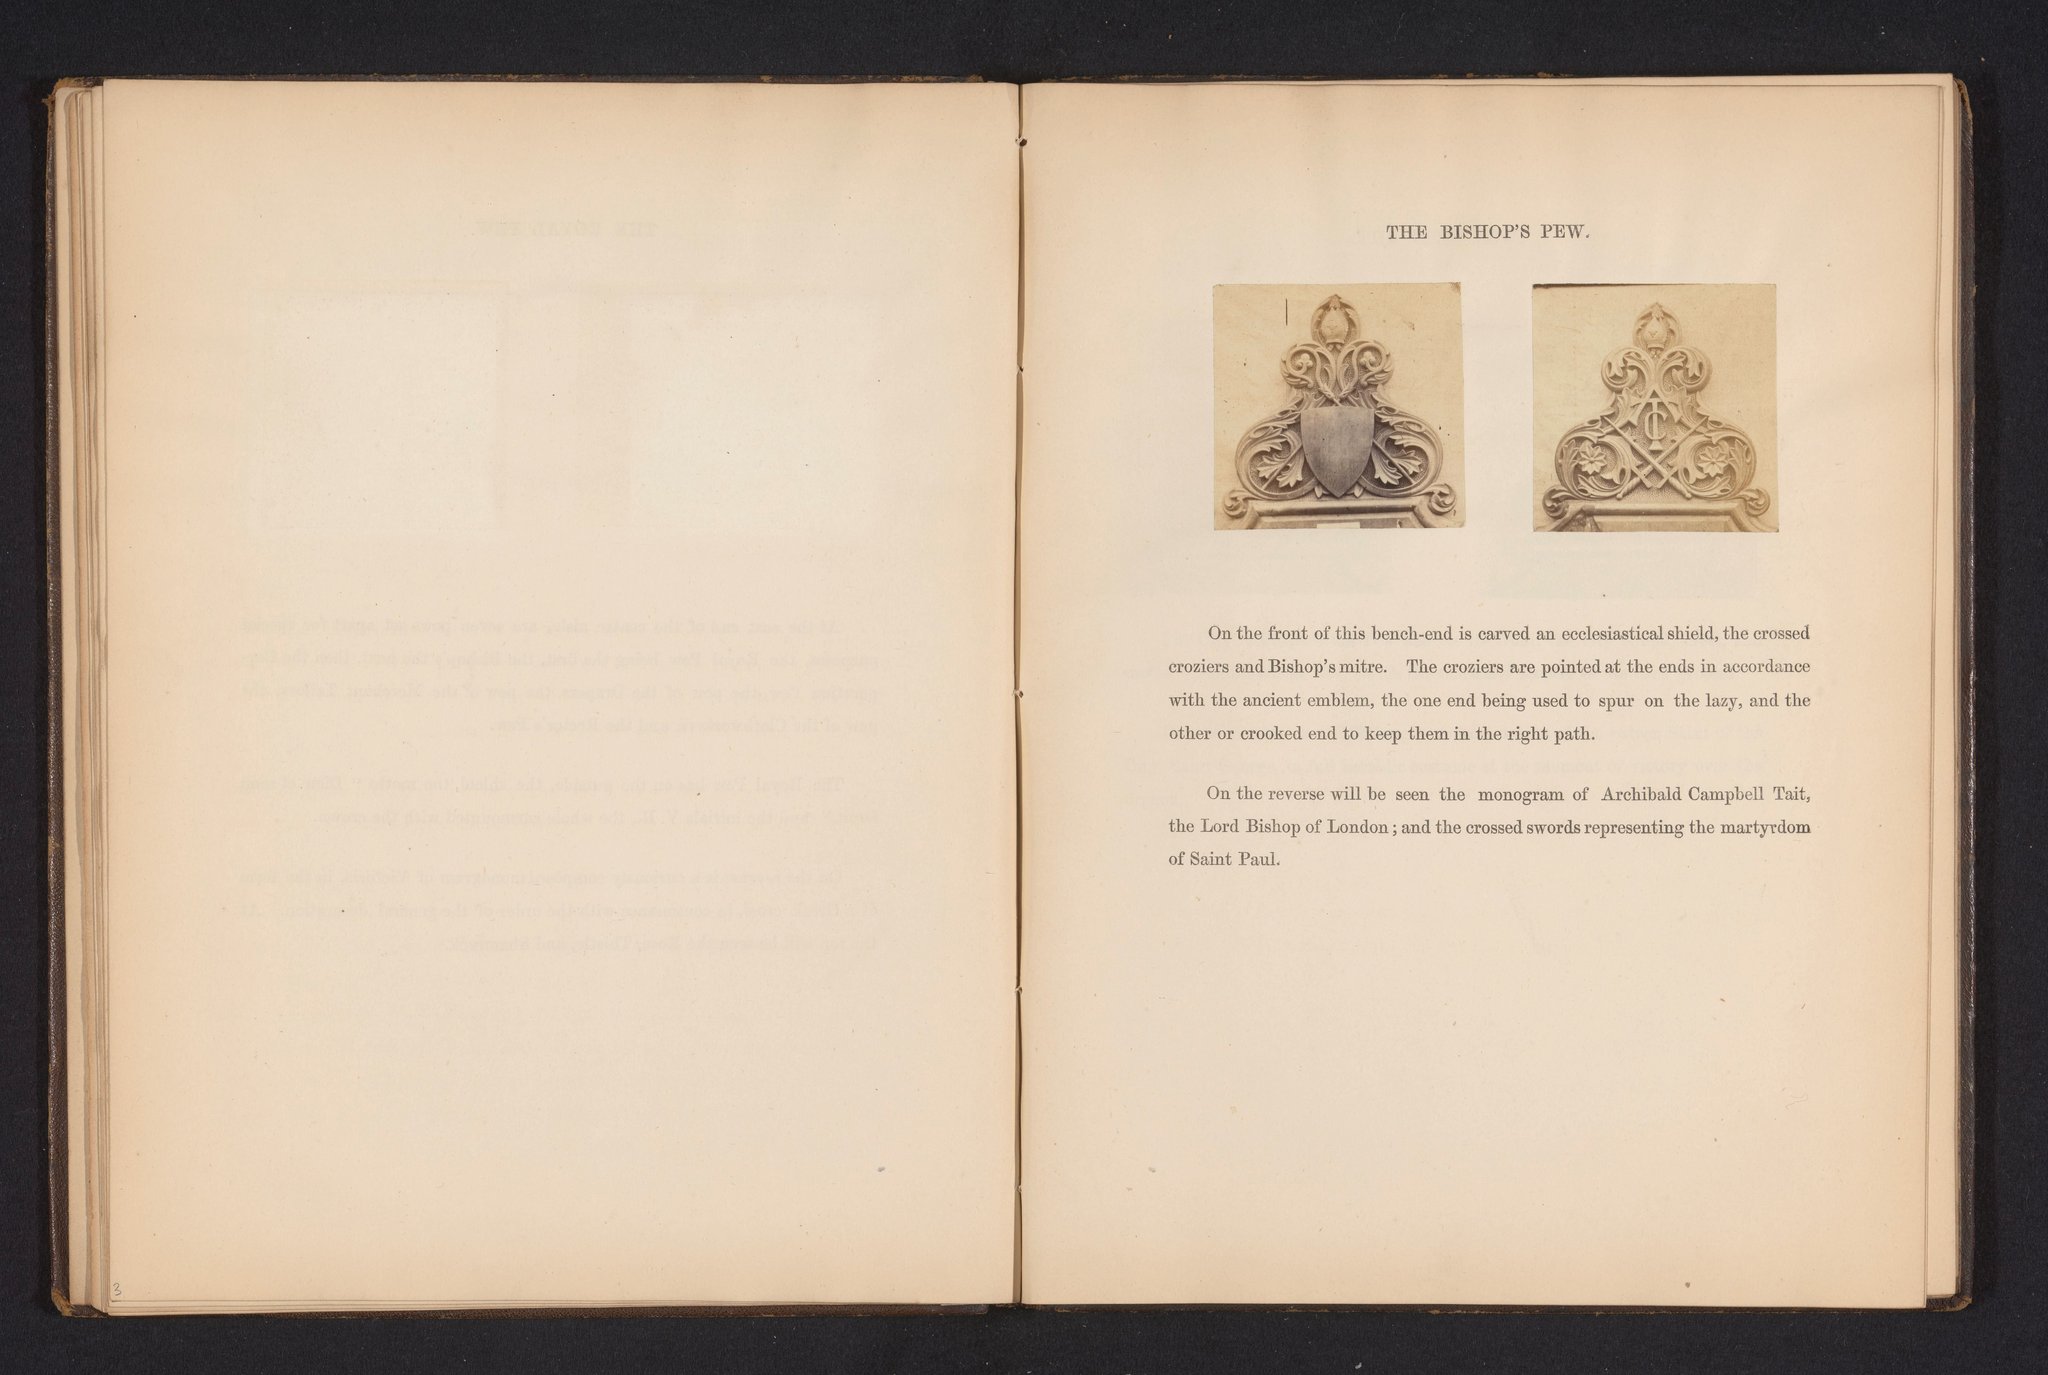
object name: photograph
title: The Bishop's pew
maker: Anonymous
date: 1857-1867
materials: photographic support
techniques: albumen print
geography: st michael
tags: coat of arms (as symbol of the state, etc.), bench, bishop's throne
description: Links: een wapenschild en een bisschopsstaf, rechts: twee zwaarden en een monogram.